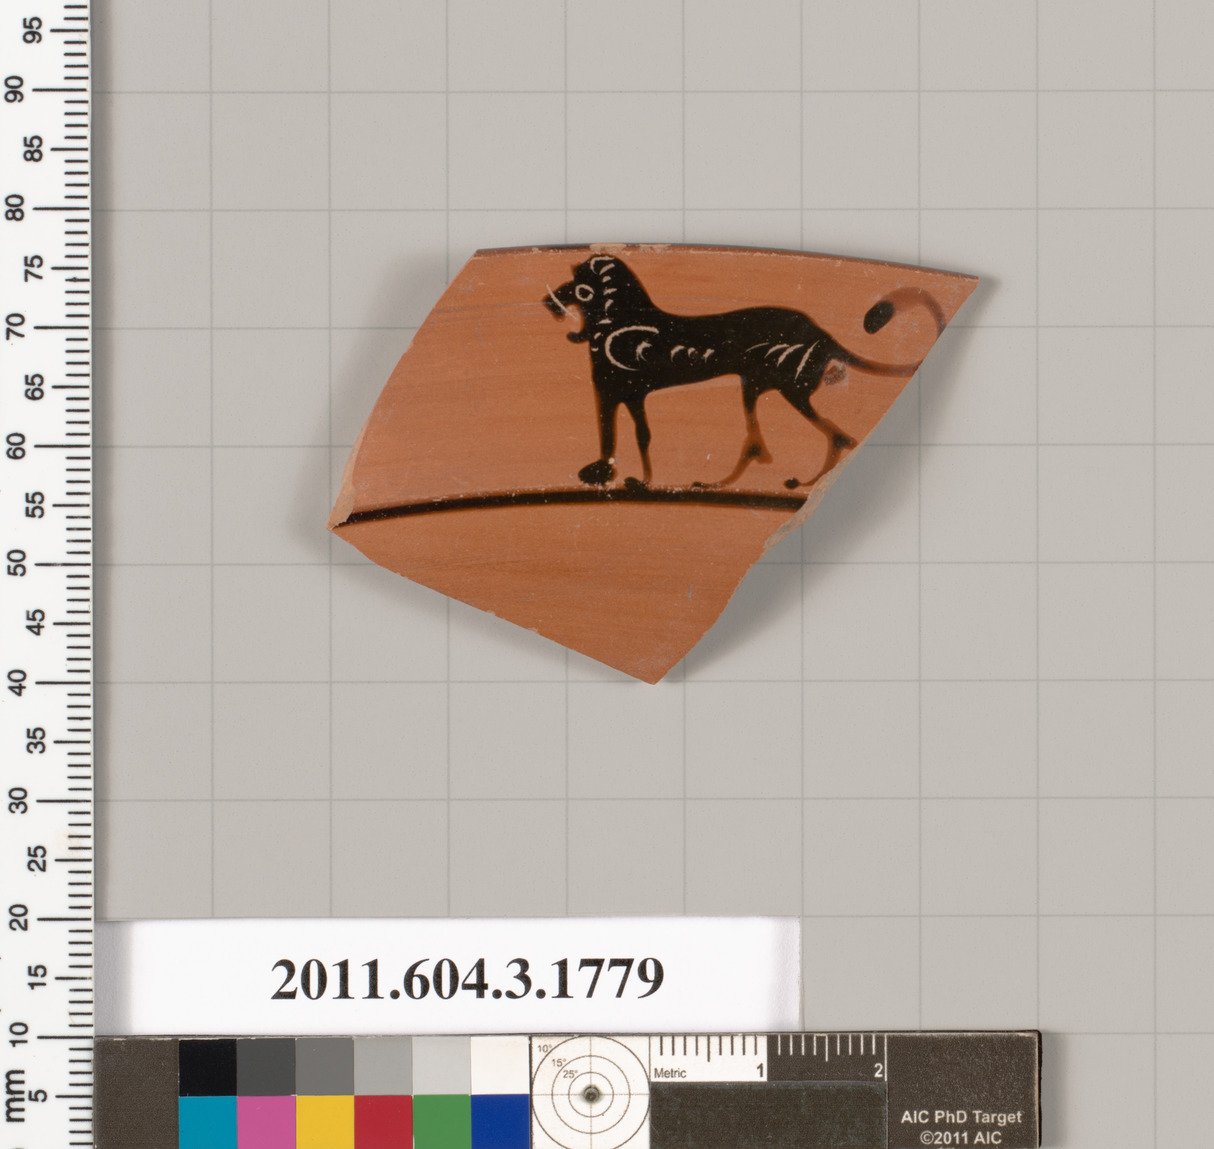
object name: kylix fragment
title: Terracotta rim fragment of a kylix: Lip cup (drinking cup)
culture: greek, attic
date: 550-526 BCE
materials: terracotta